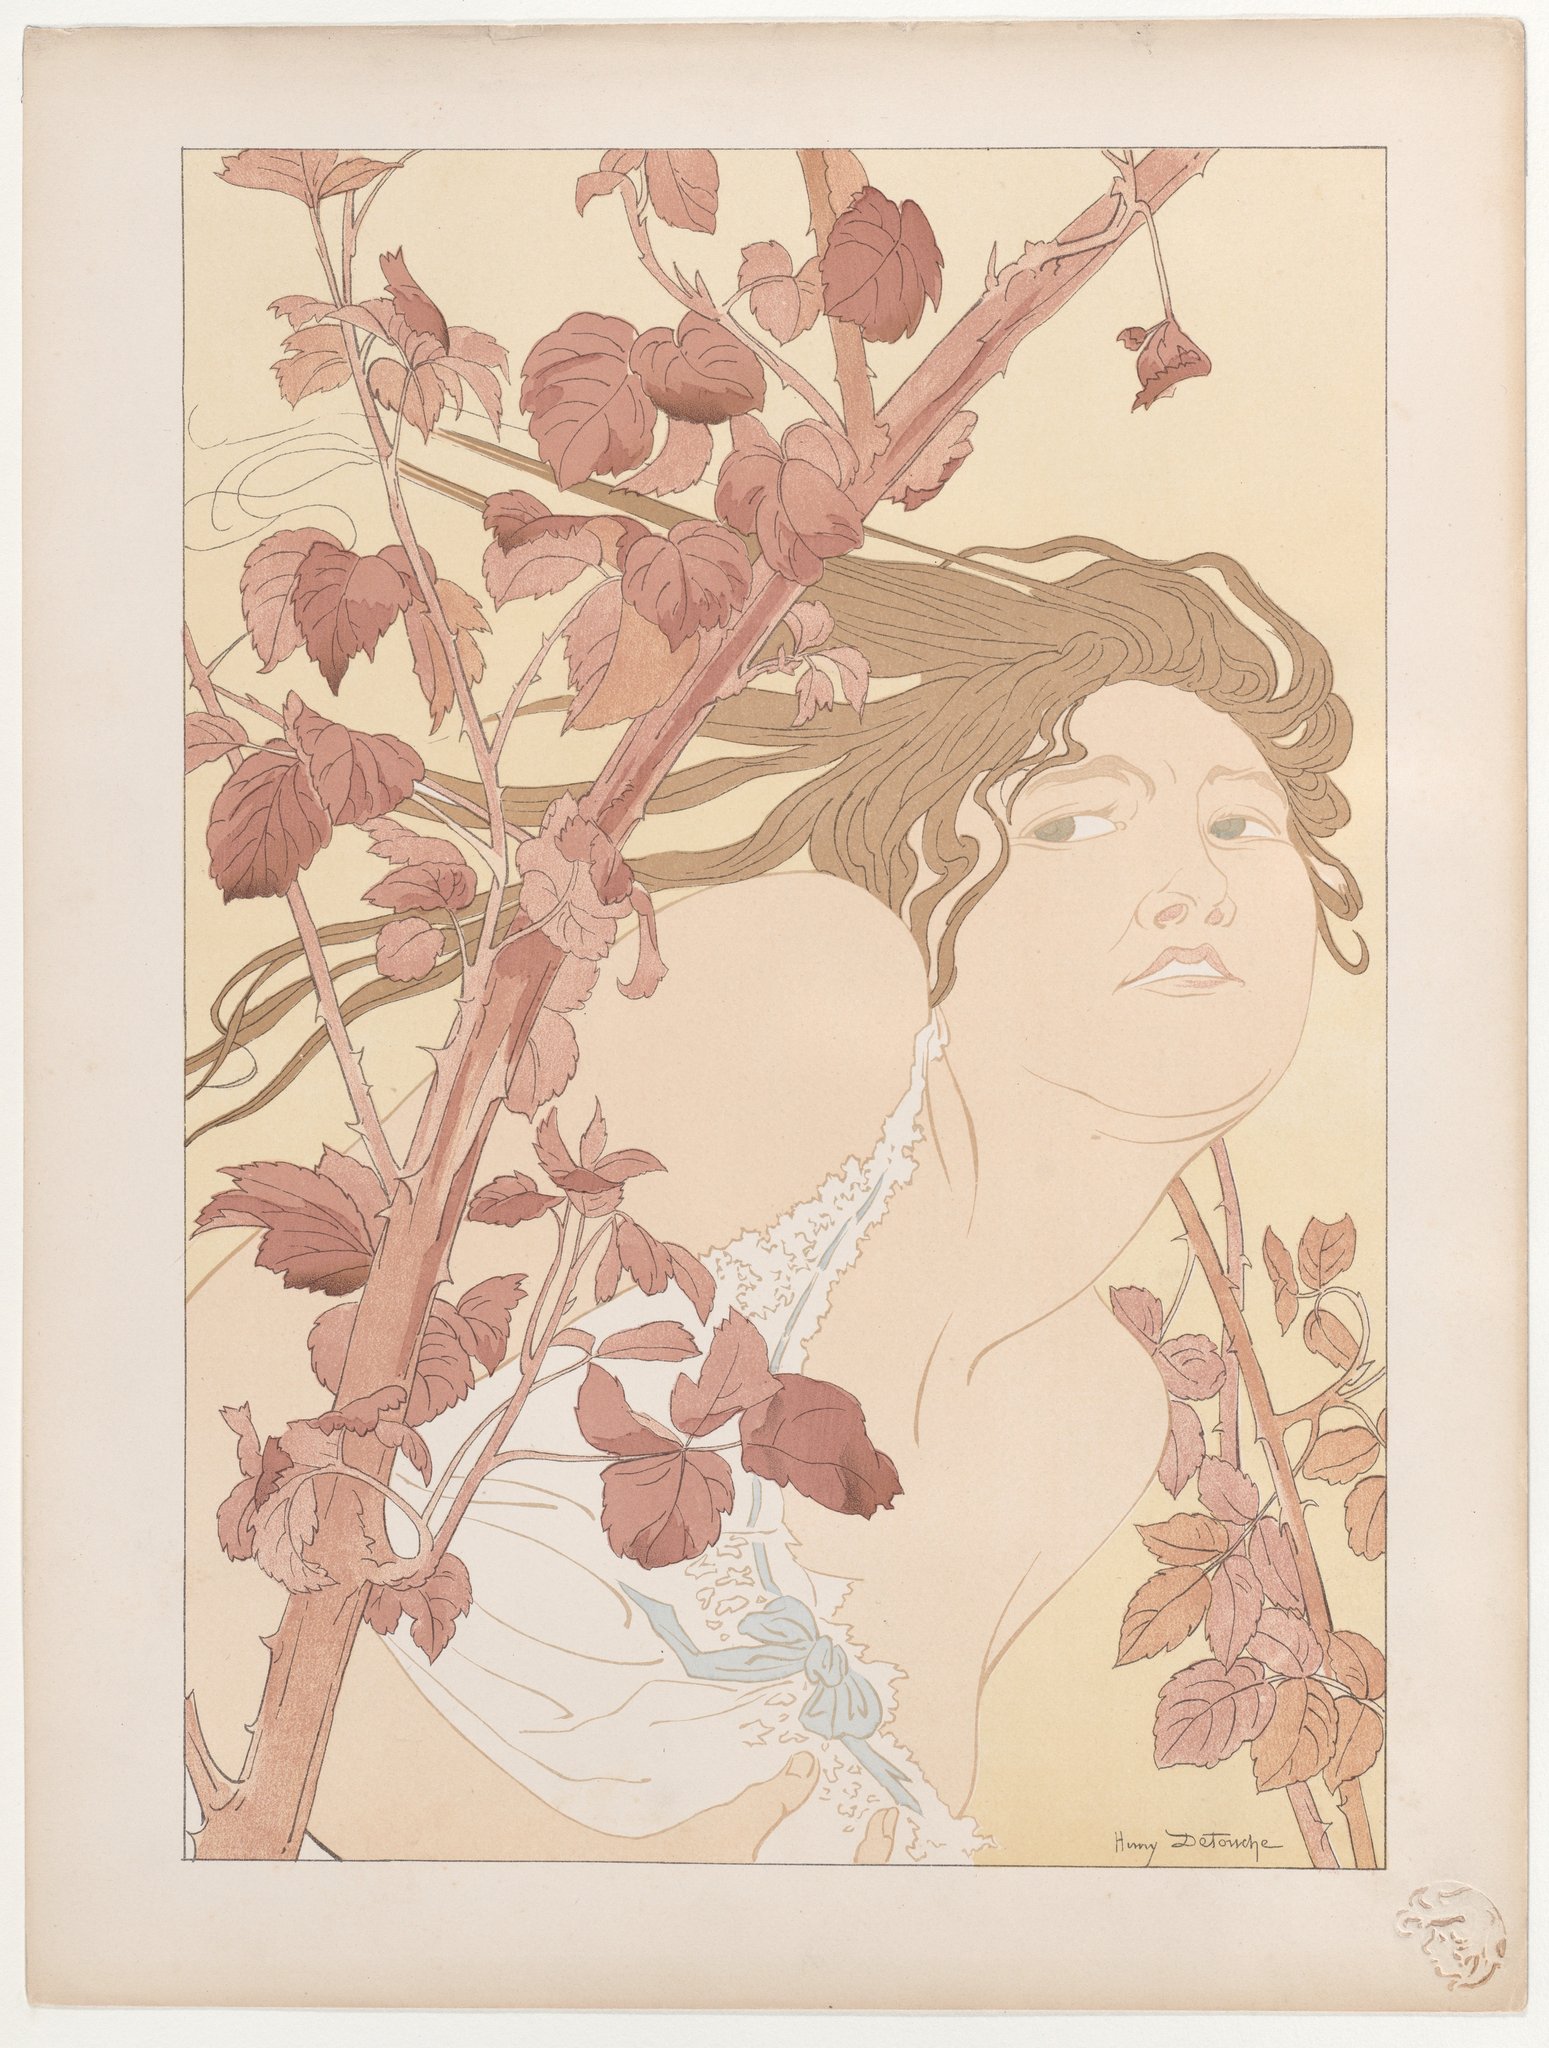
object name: print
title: In the Brambles (Dans les Ronces), from "L'Estampe Moderne"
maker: henry julien detouche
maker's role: artist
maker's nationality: french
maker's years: 1854-1913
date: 1897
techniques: lithograph